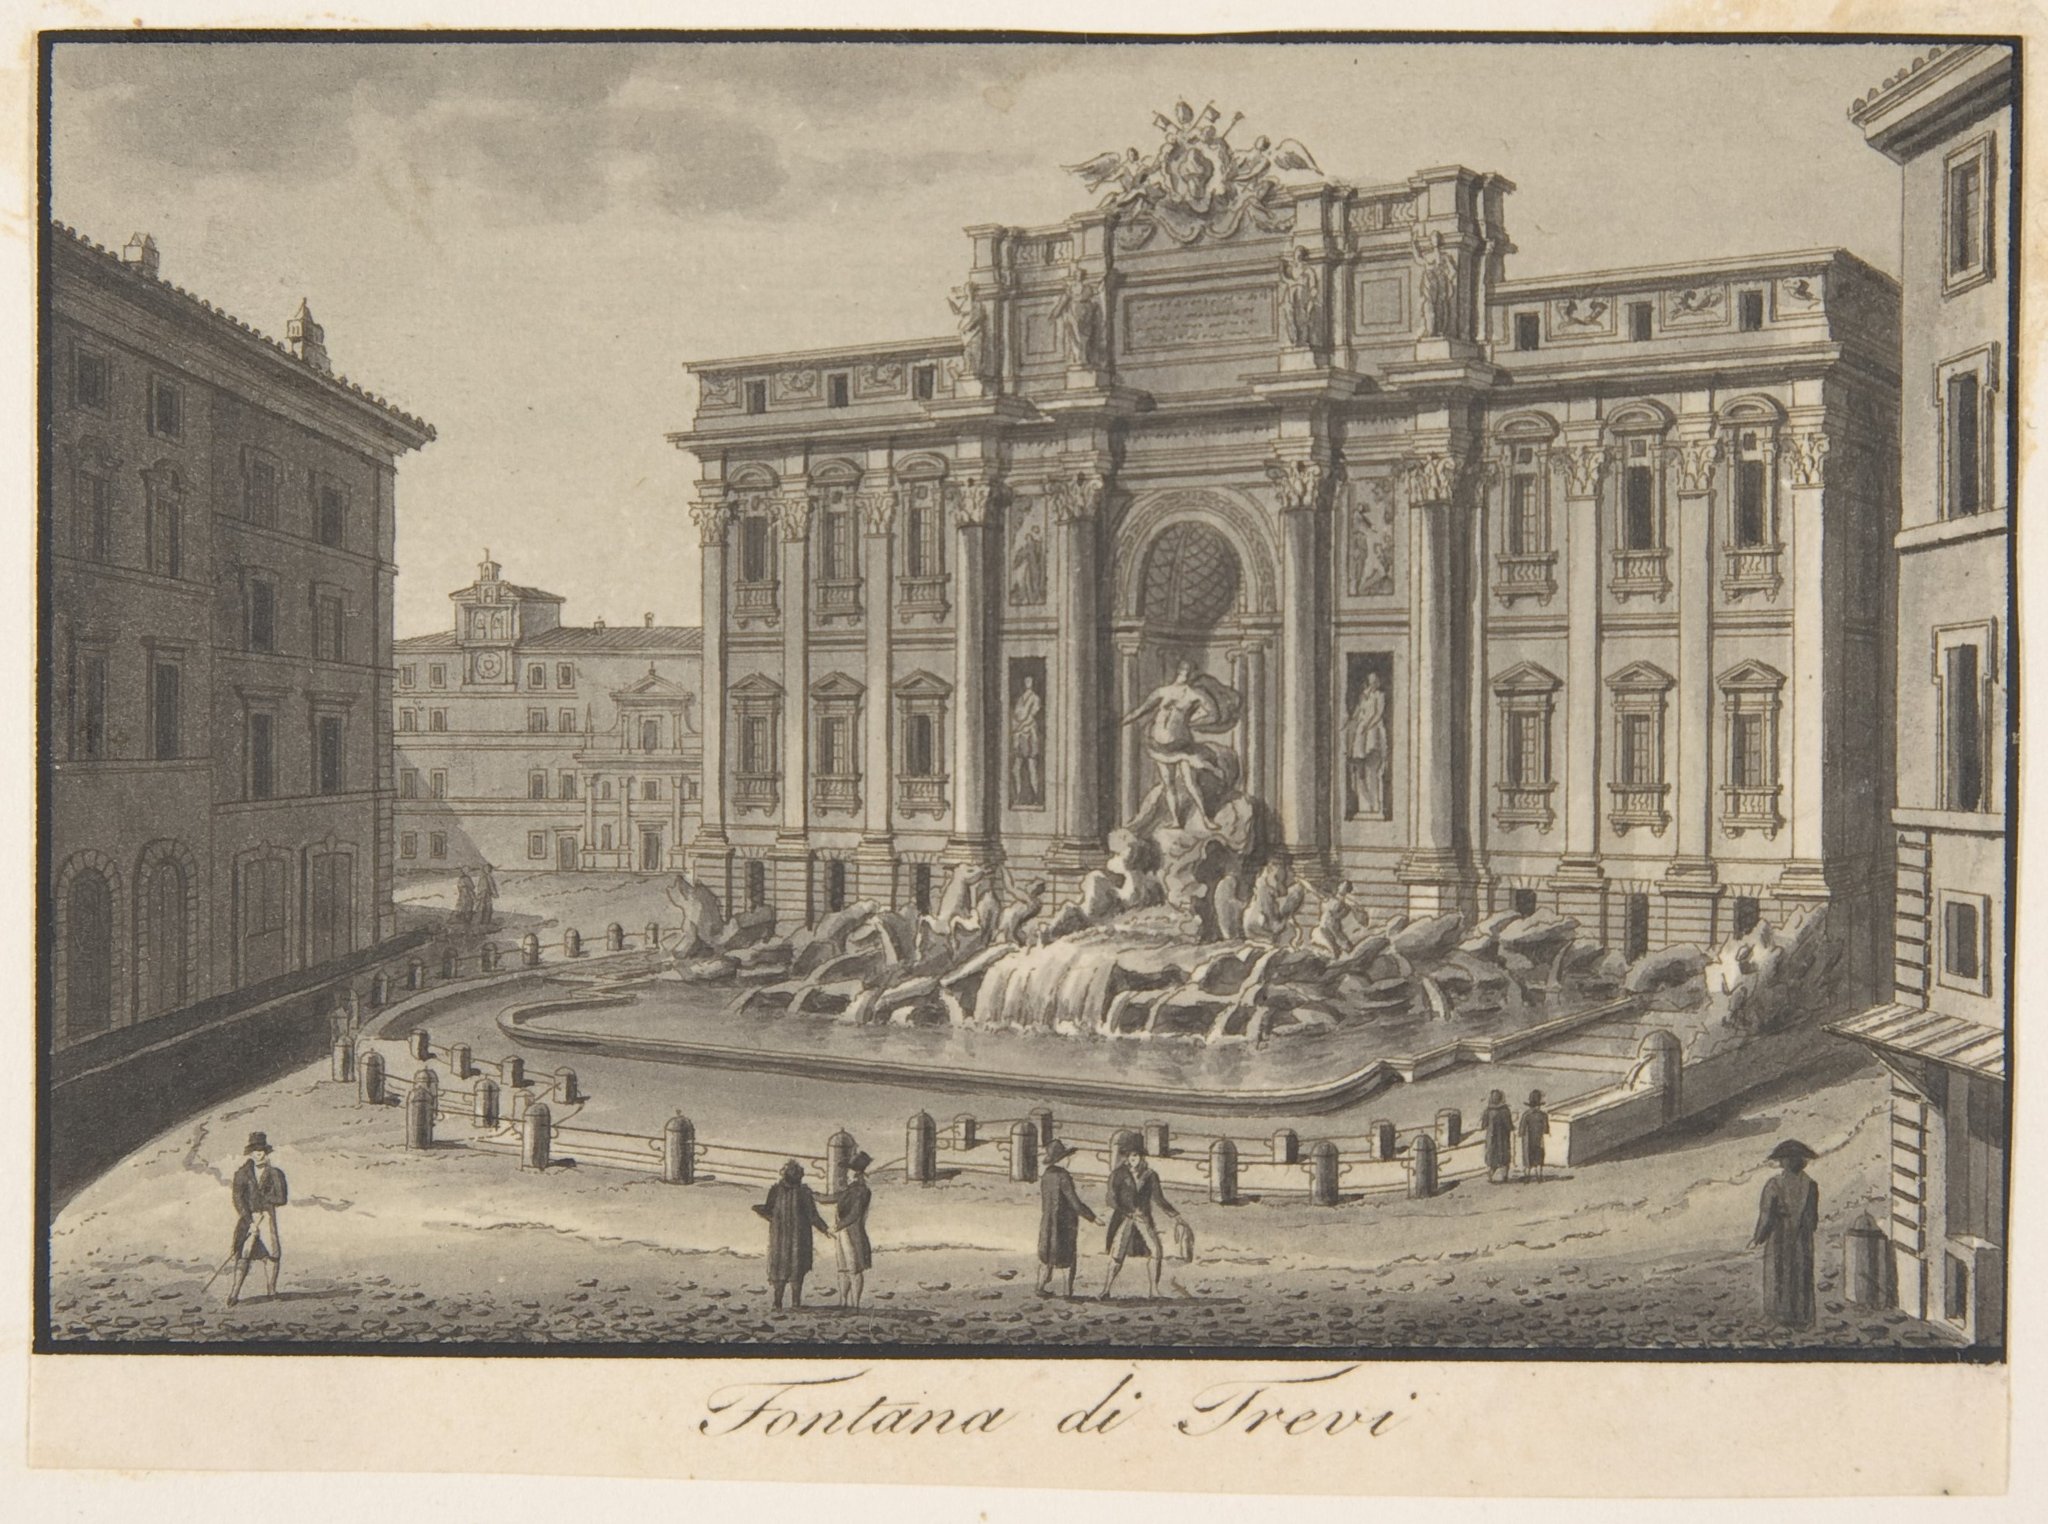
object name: drawing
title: The Trevi Fountain, Rome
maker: giovanni battista cipriani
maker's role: artist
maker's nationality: italian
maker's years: 1766-1839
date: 1767-1866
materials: ink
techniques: drawing, pen, wash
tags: buildings,fountains,rome